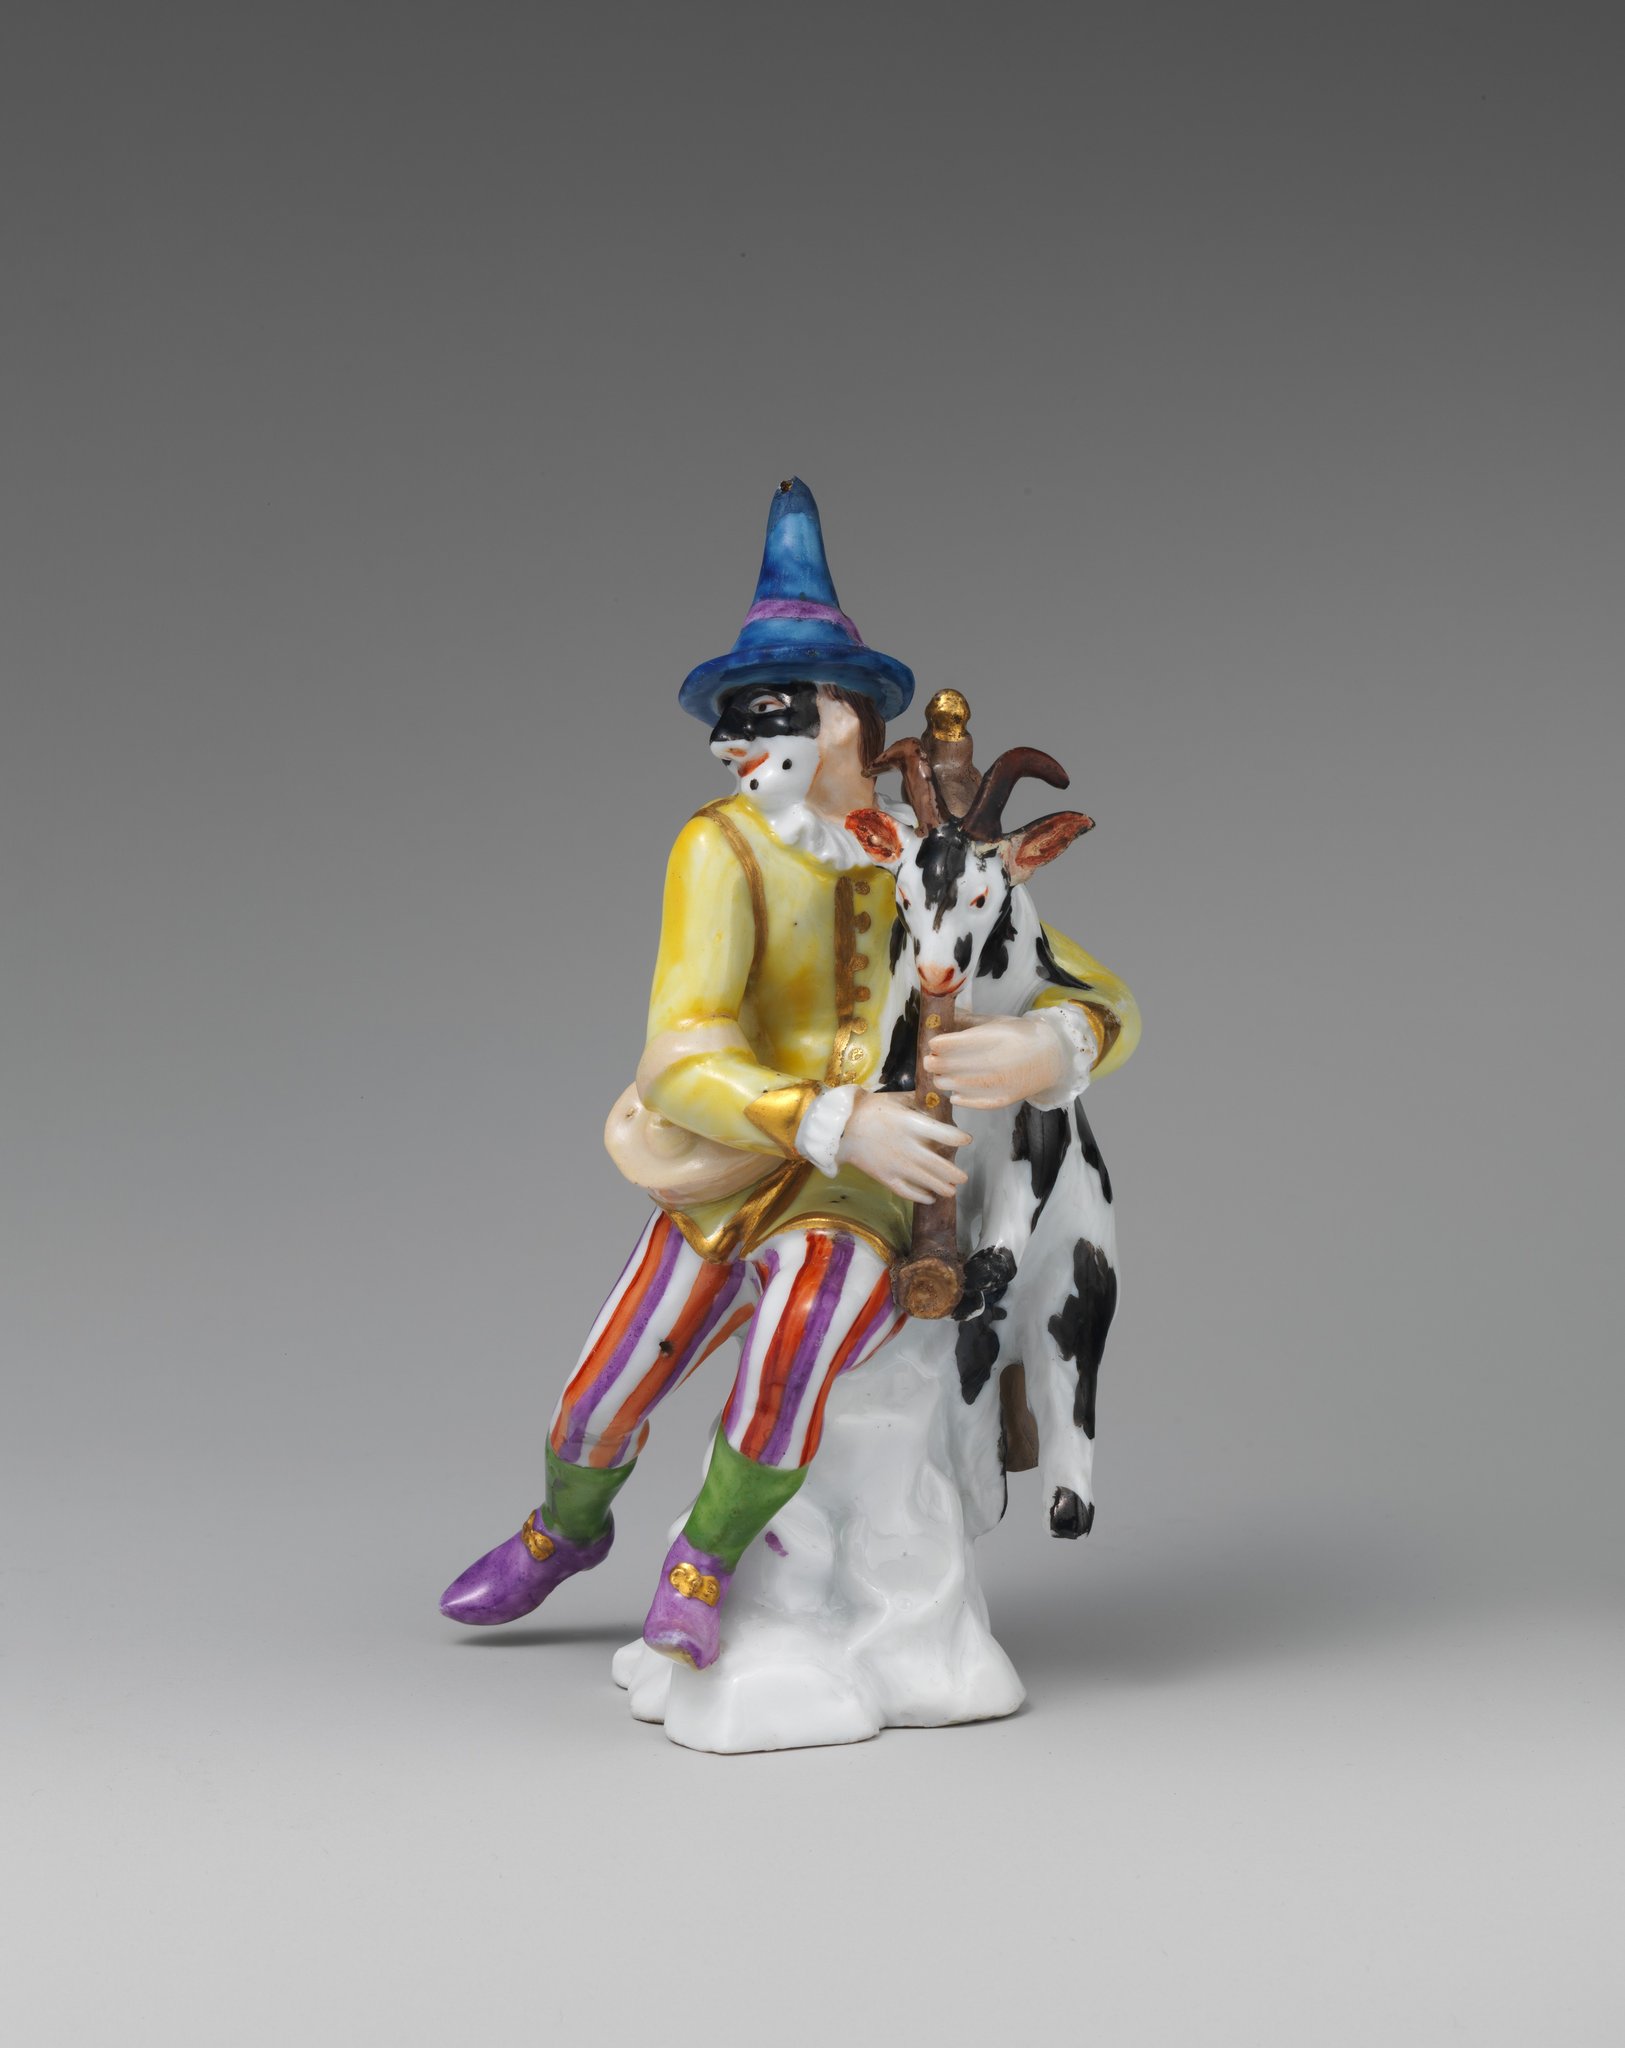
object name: figure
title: Harlequin with Goat as Bagpipes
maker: meissen manufactory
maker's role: manufactory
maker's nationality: german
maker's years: 1710-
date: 1736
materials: hard paste porcelain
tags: men,bagpipes,goats